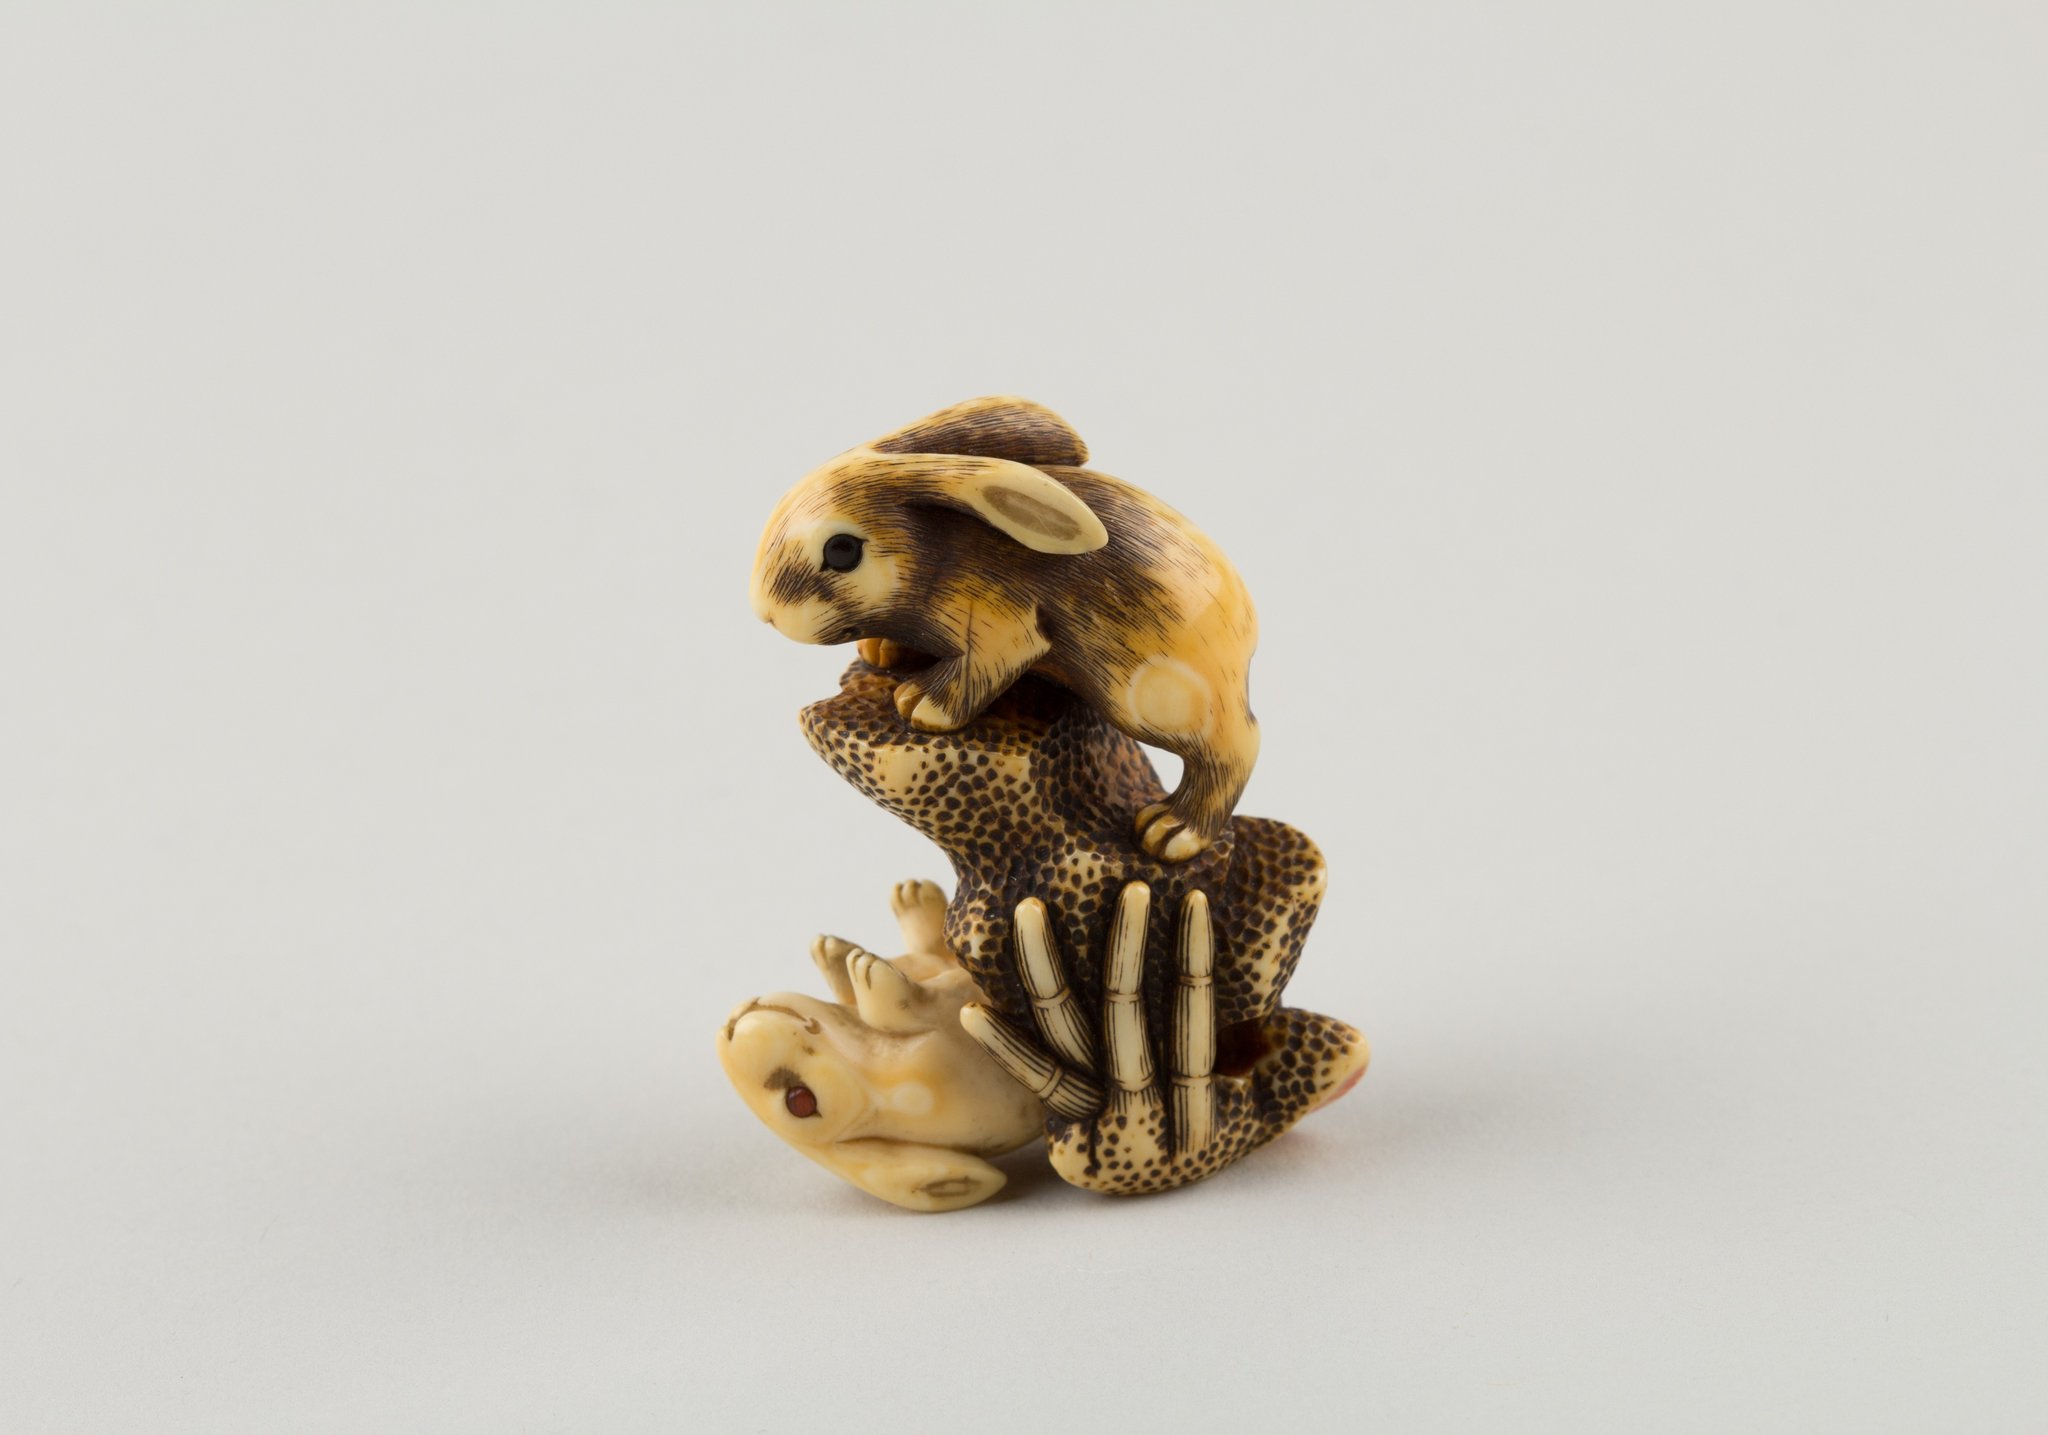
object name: netsuke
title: Netsuke of Two Rabbits and a Rock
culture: japanese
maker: mitsuharu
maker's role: artist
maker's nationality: japanese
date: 1701-1800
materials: coral, horn, ivory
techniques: inlay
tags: rabbits